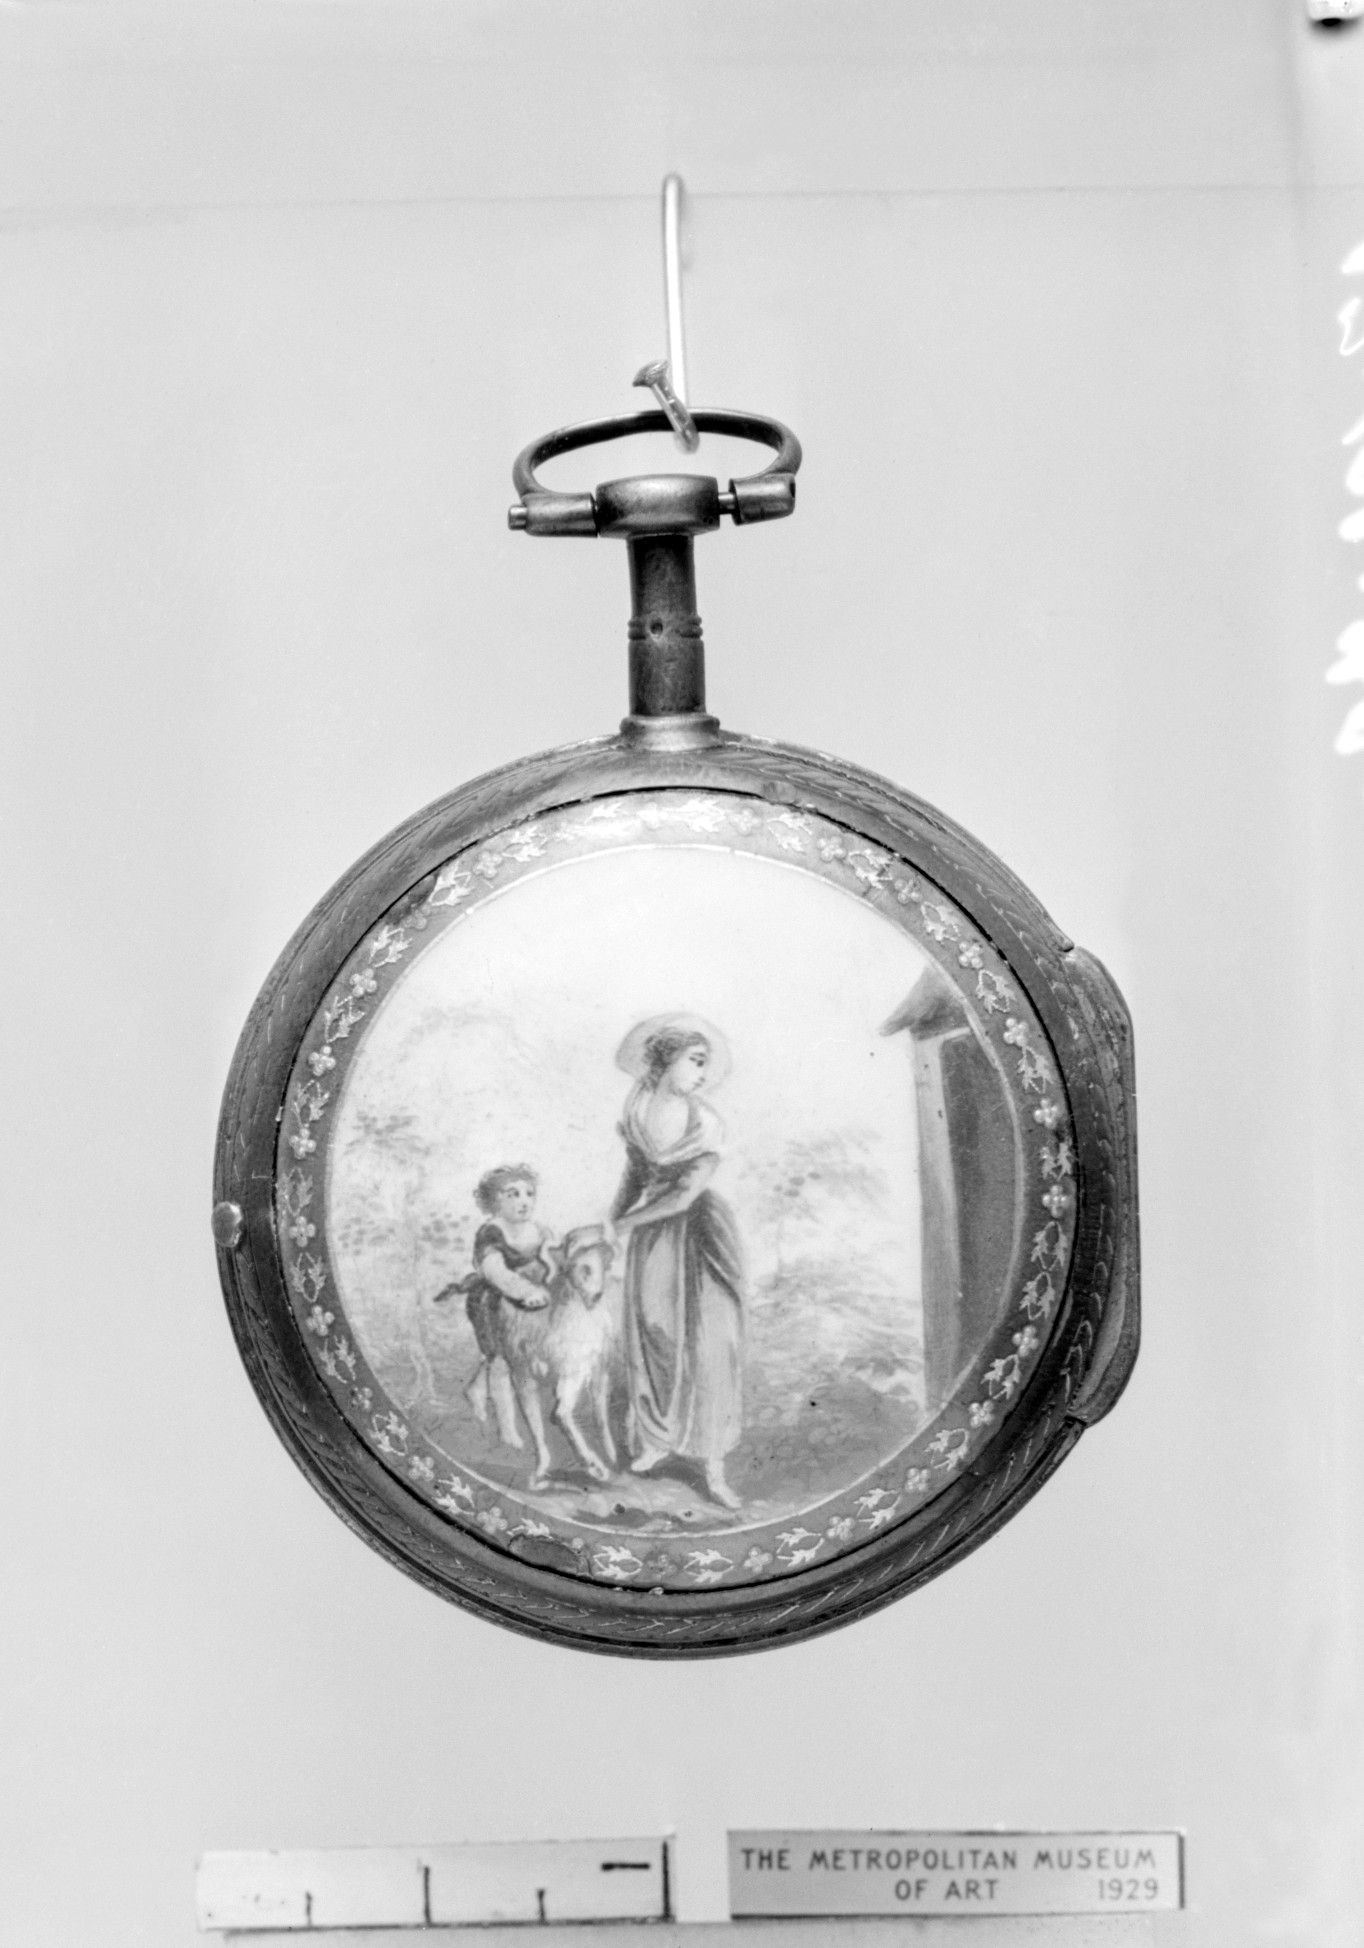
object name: watch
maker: j.c. scherer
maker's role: maker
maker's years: 1750-1850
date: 1767-1800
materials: gilt copper, enamel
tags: girls,women,sheep